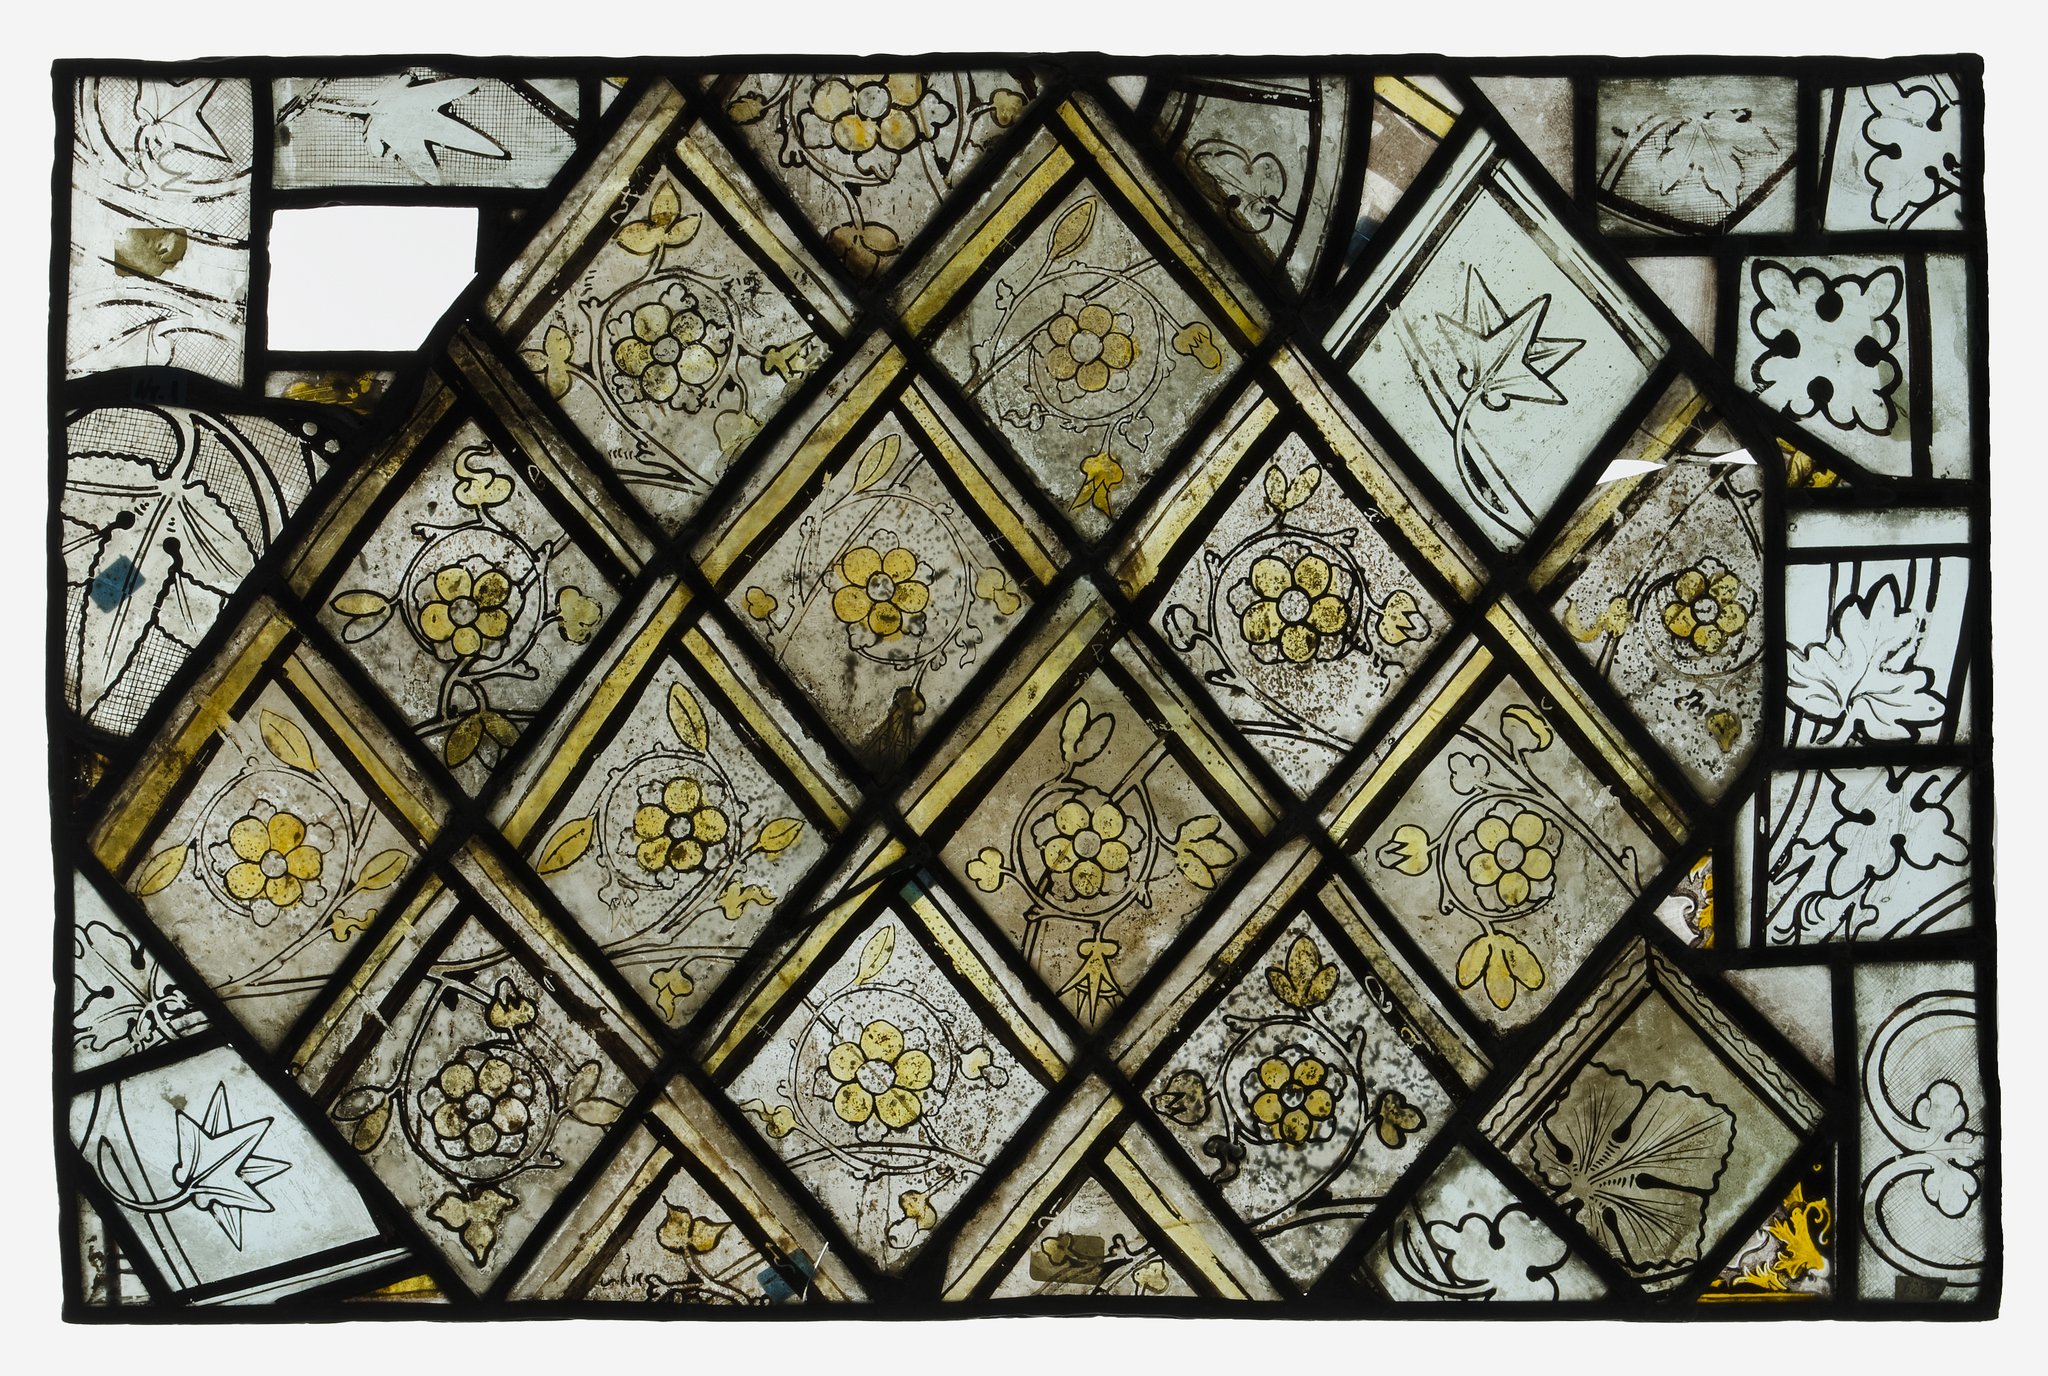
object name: panel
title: Panel Panel with Grisaille in a Wild-Rose Pattern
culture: french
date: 1325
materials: glass, paint, pigment